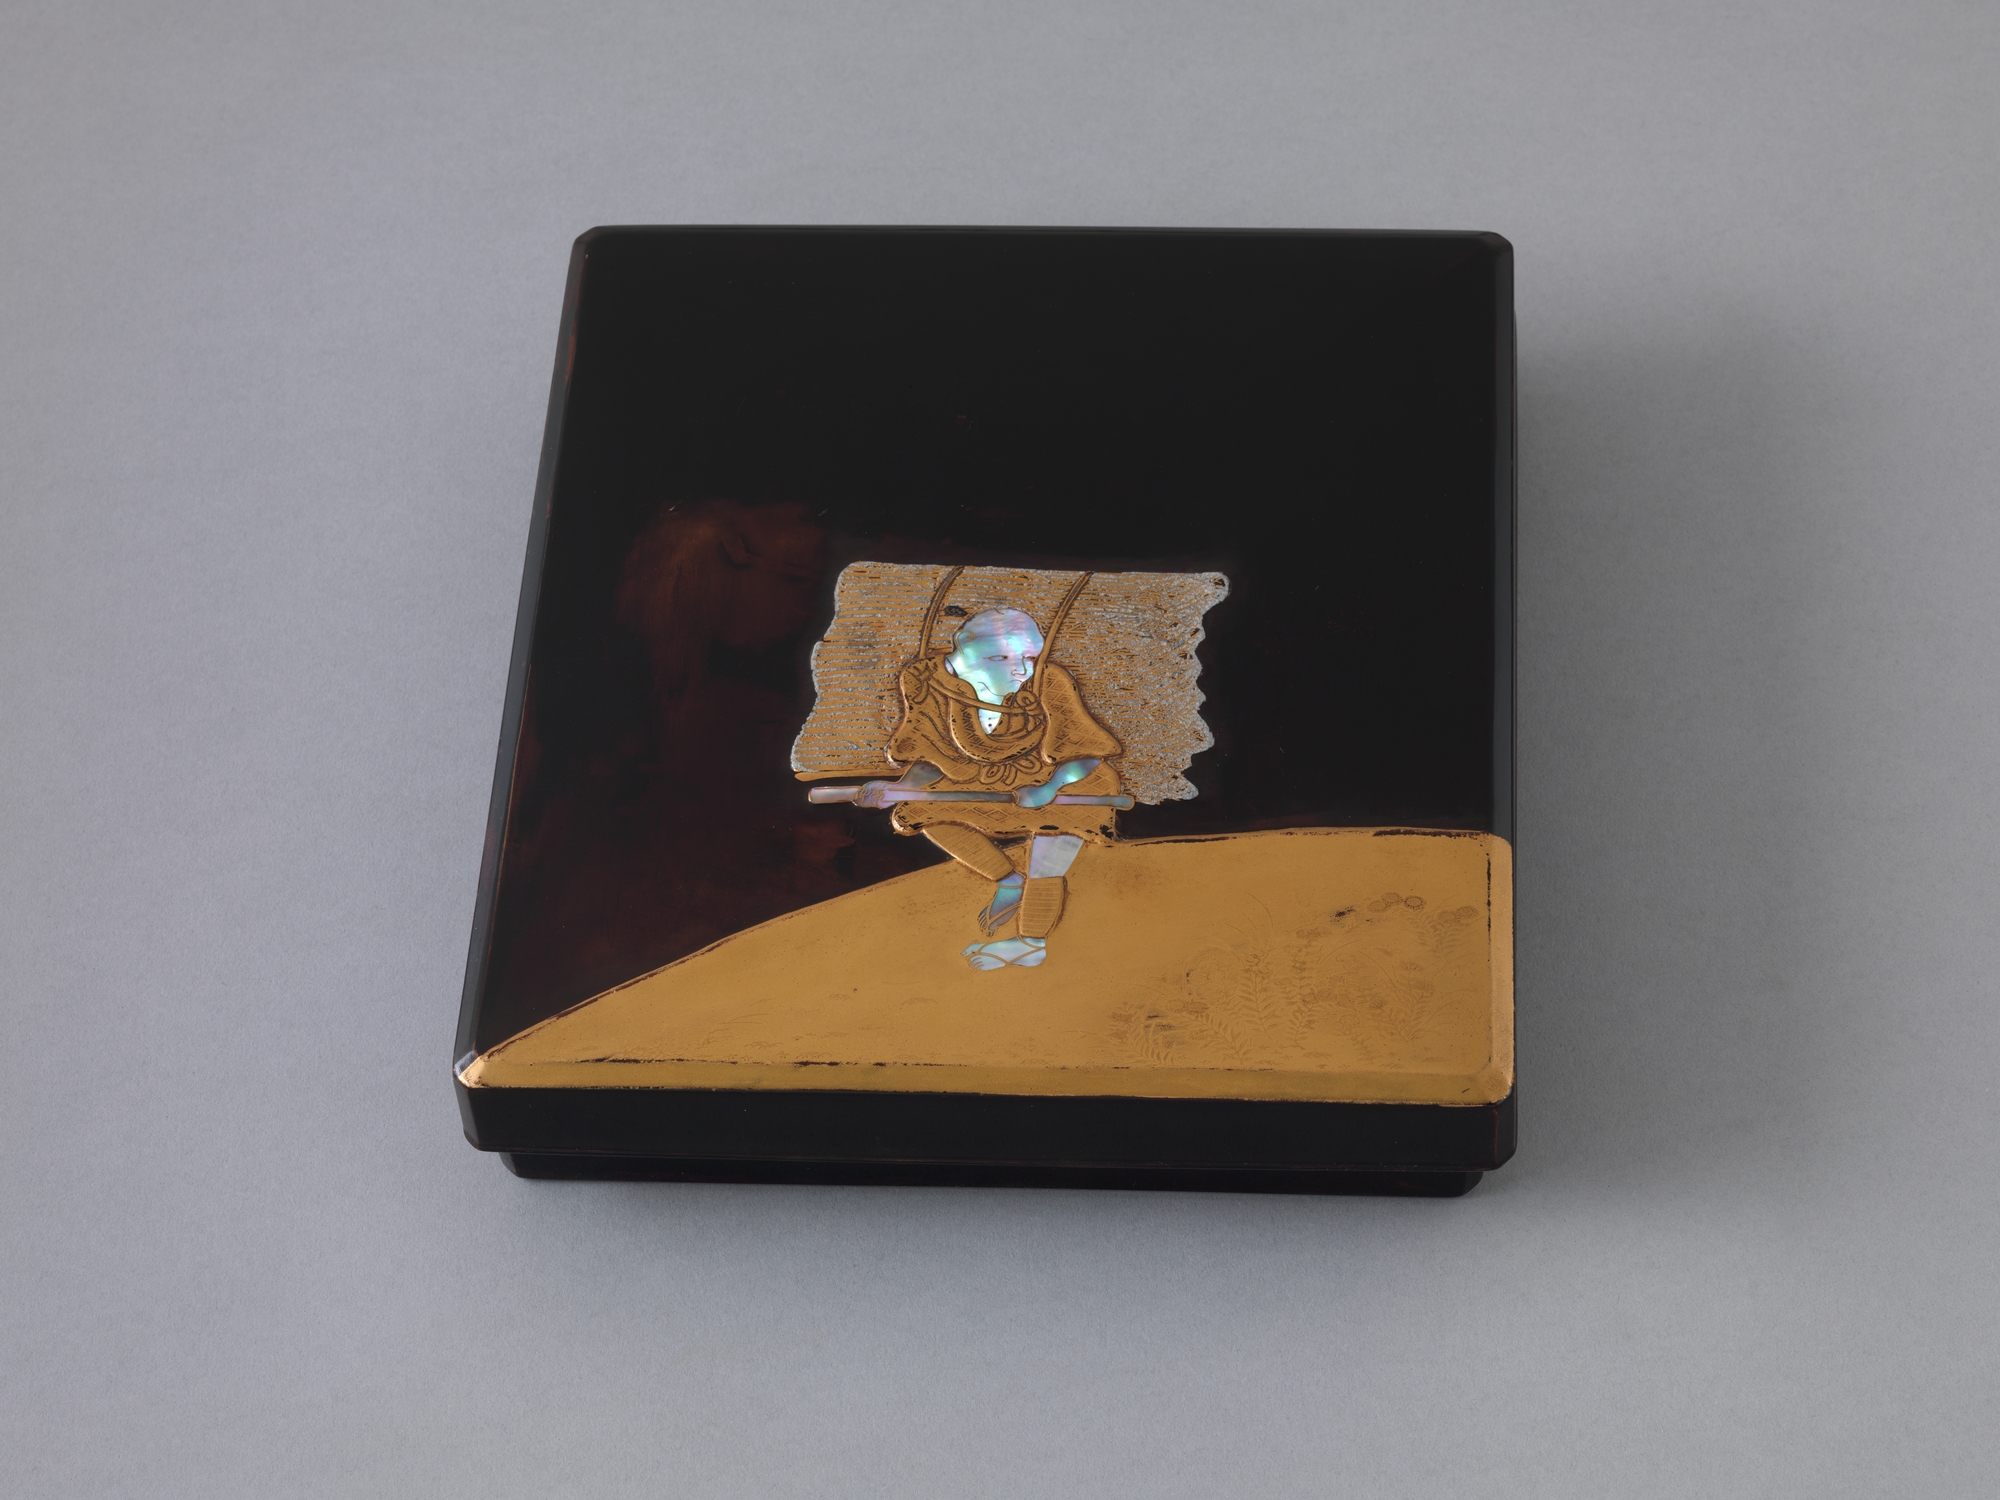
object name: writing box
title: Writing Box (Suzuribako) with Woodcutter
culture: japanese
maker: ogata kōrin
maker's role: artist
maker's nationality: japanese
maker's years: 1658-1716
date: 1801-1900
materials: gold, lacquer, mother of pearl, wood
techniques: inlay, maki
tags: men